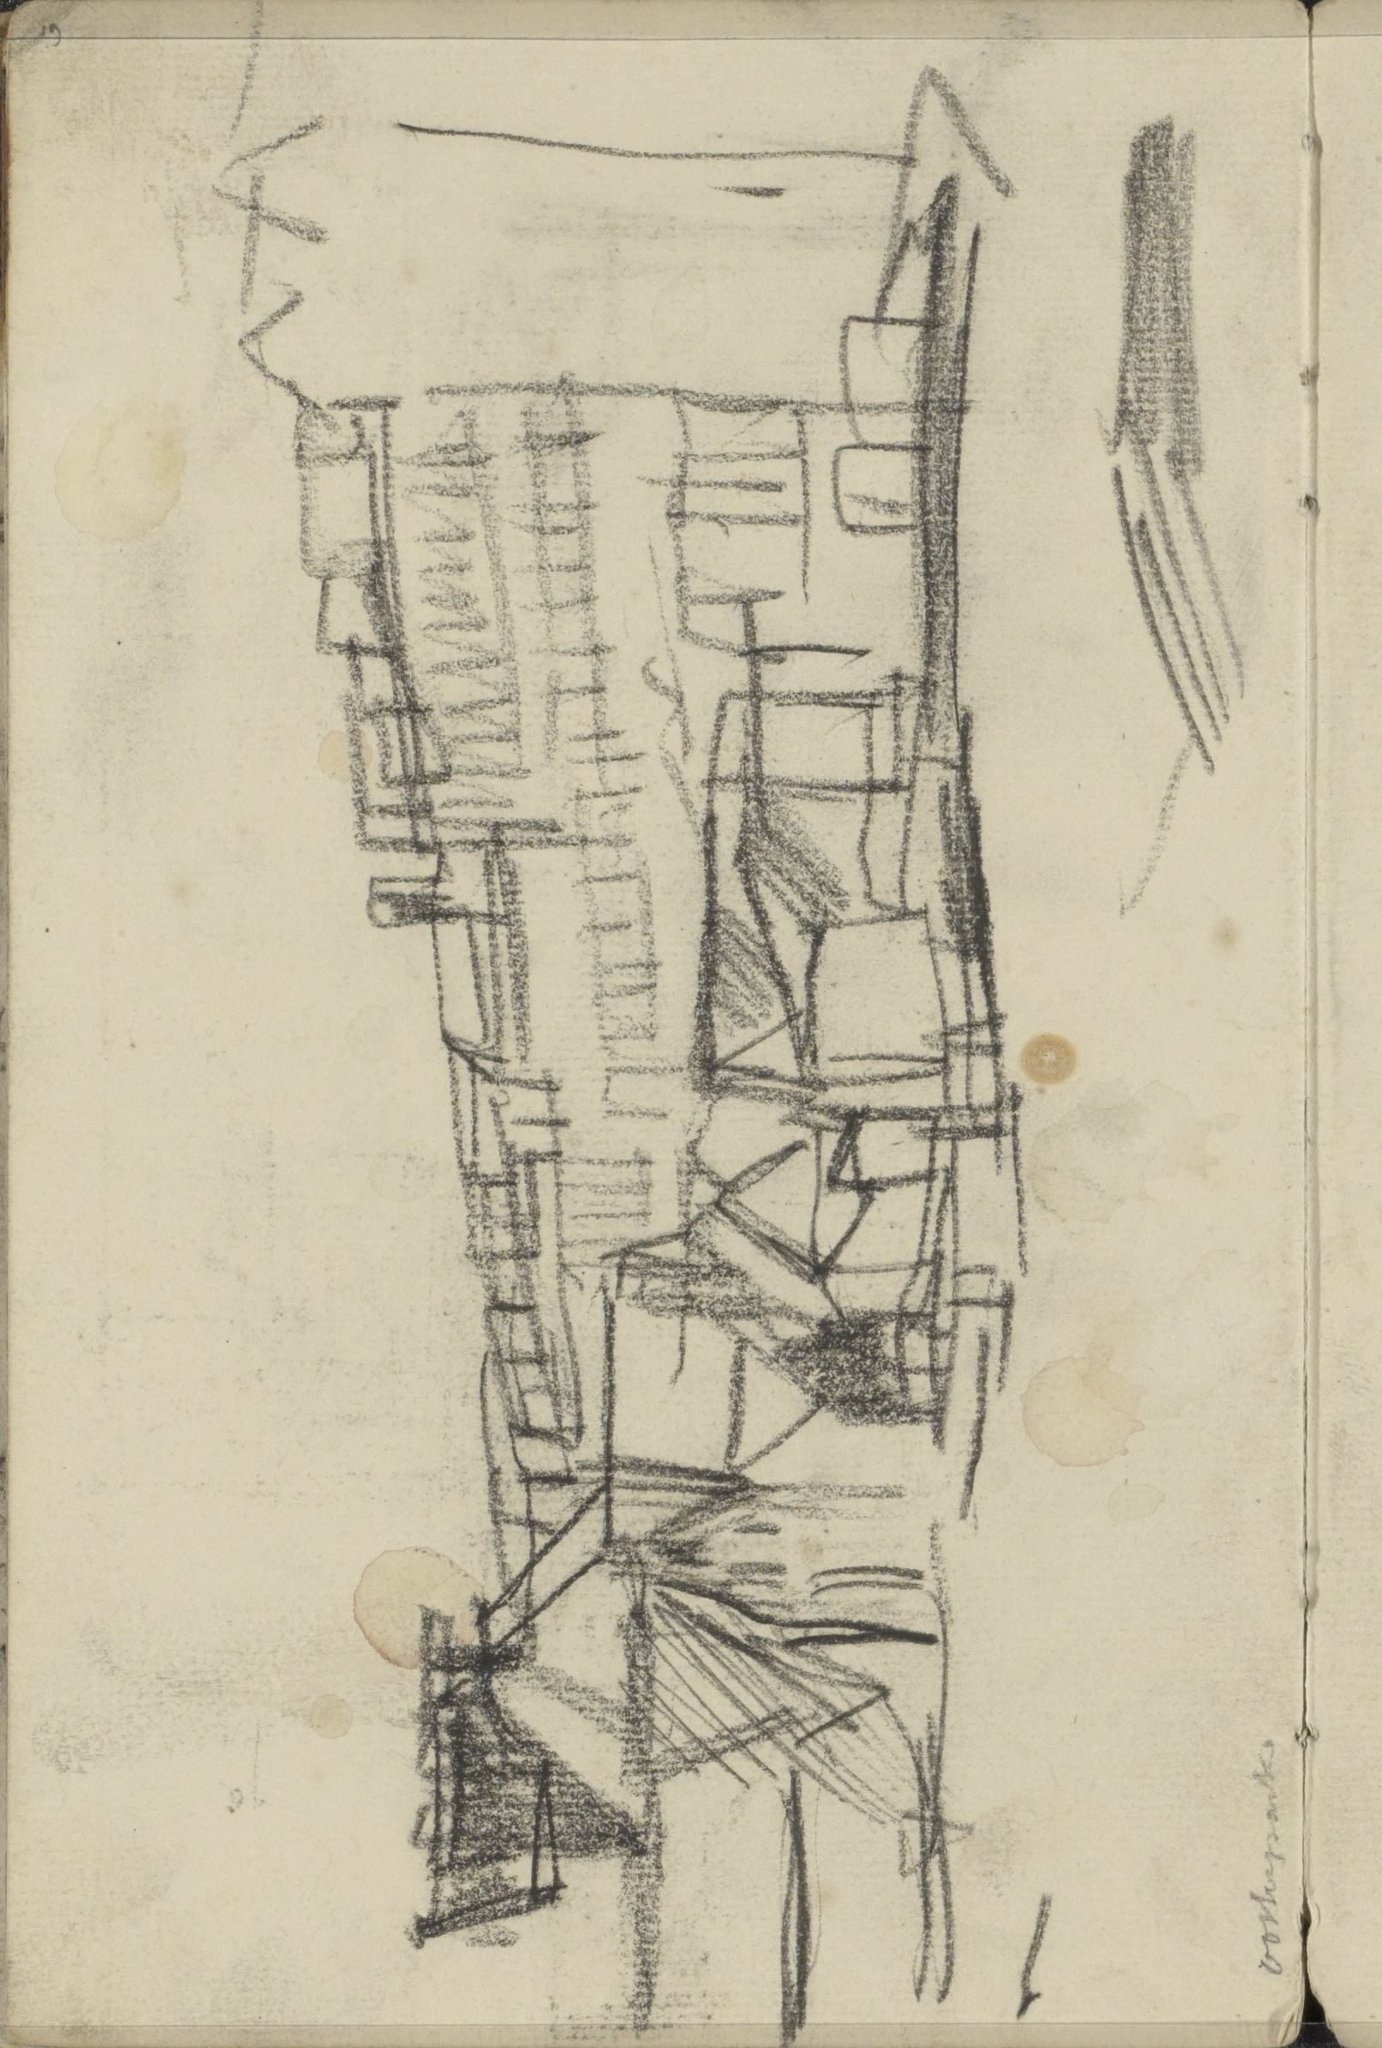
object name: sketchbook leaf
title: Gezicht op het Oosterpark te Amsterdam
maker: george hendrik breitner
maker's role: draughtsman, painter, print maker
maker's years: 1857-1923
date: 1888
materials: chalk, paper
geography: amsterdam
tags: park, civic architecture; edifices; dwellings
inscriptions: annotation: ‘Oosterpark’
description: Bebouwing aan de rand van het toekomstige Oosterpark. Pagina 19 uit een schetsboek met 17 bladen.